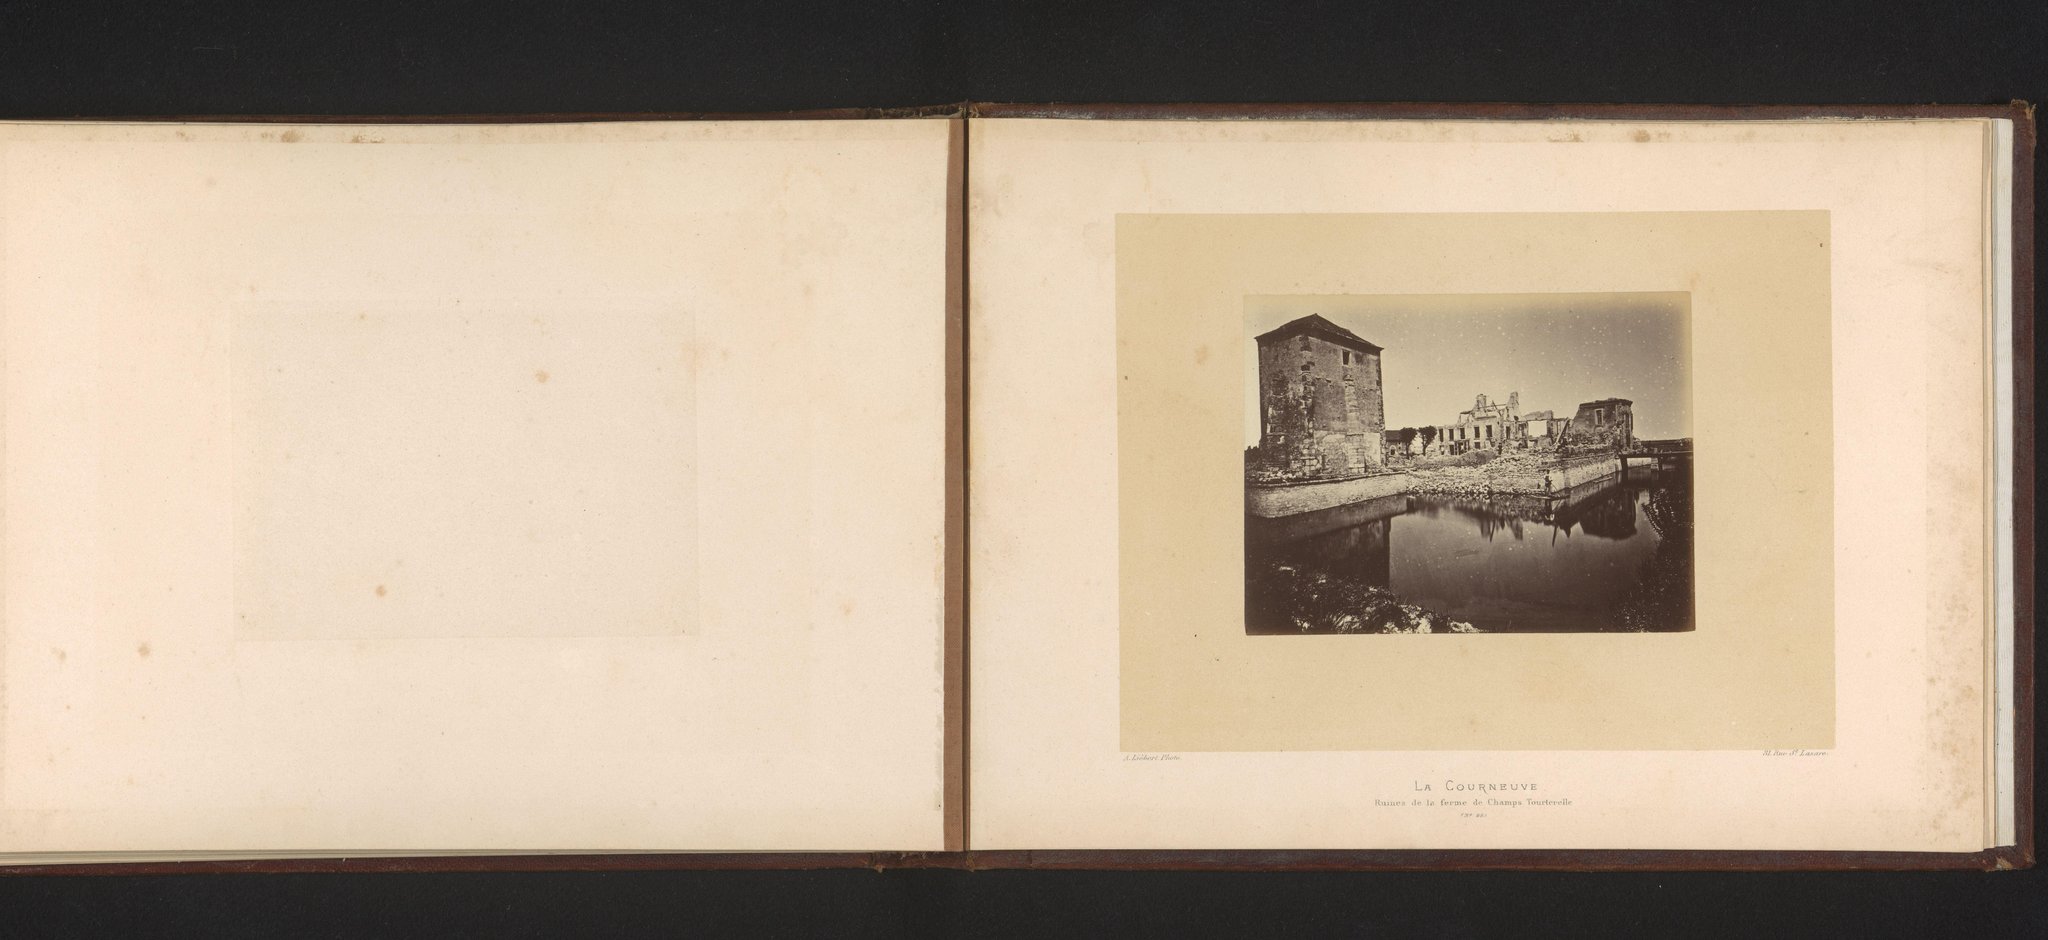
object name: photograph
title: Gezicht op de resten van een boerderij in La Courneuve na de verwoesting door de Commune van Parijs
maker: alphonse-justin liébert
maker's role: fotograaf, marinier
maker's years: 1827-1914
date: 1871-1872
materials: photographic support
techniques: albumen print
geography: la courneuve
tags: ruin of a building ~ architecture, farm (building)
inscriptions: number: ‘(No. 98)’, address: ‘31, Rue St. Lazare’